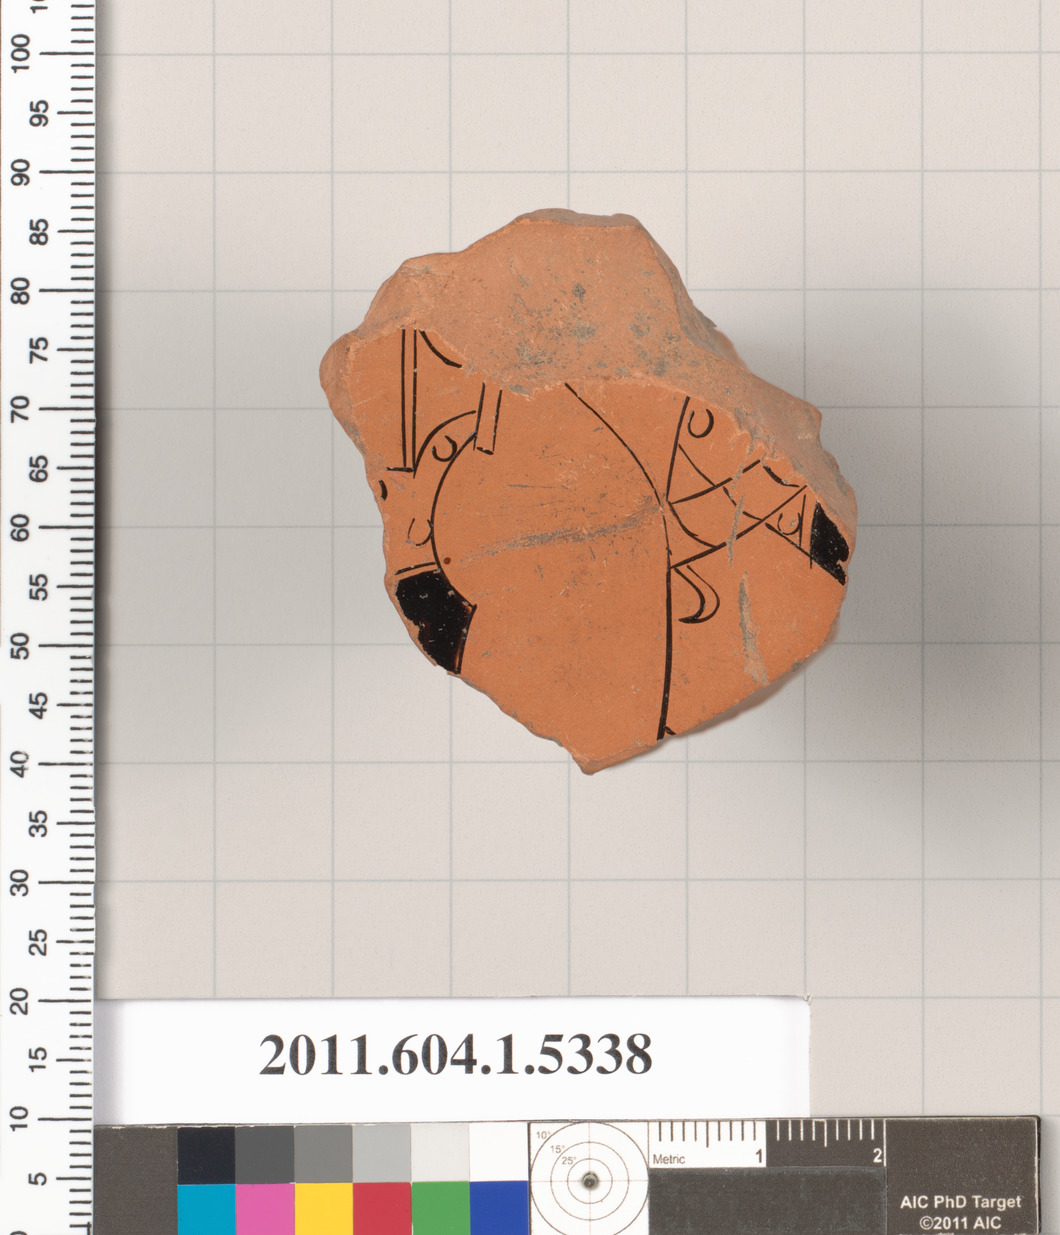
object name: kylix fragment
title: Terracotta fragment of a kylix (drinking cup)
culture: greek, attic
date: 500-480 BCE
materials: terracotta